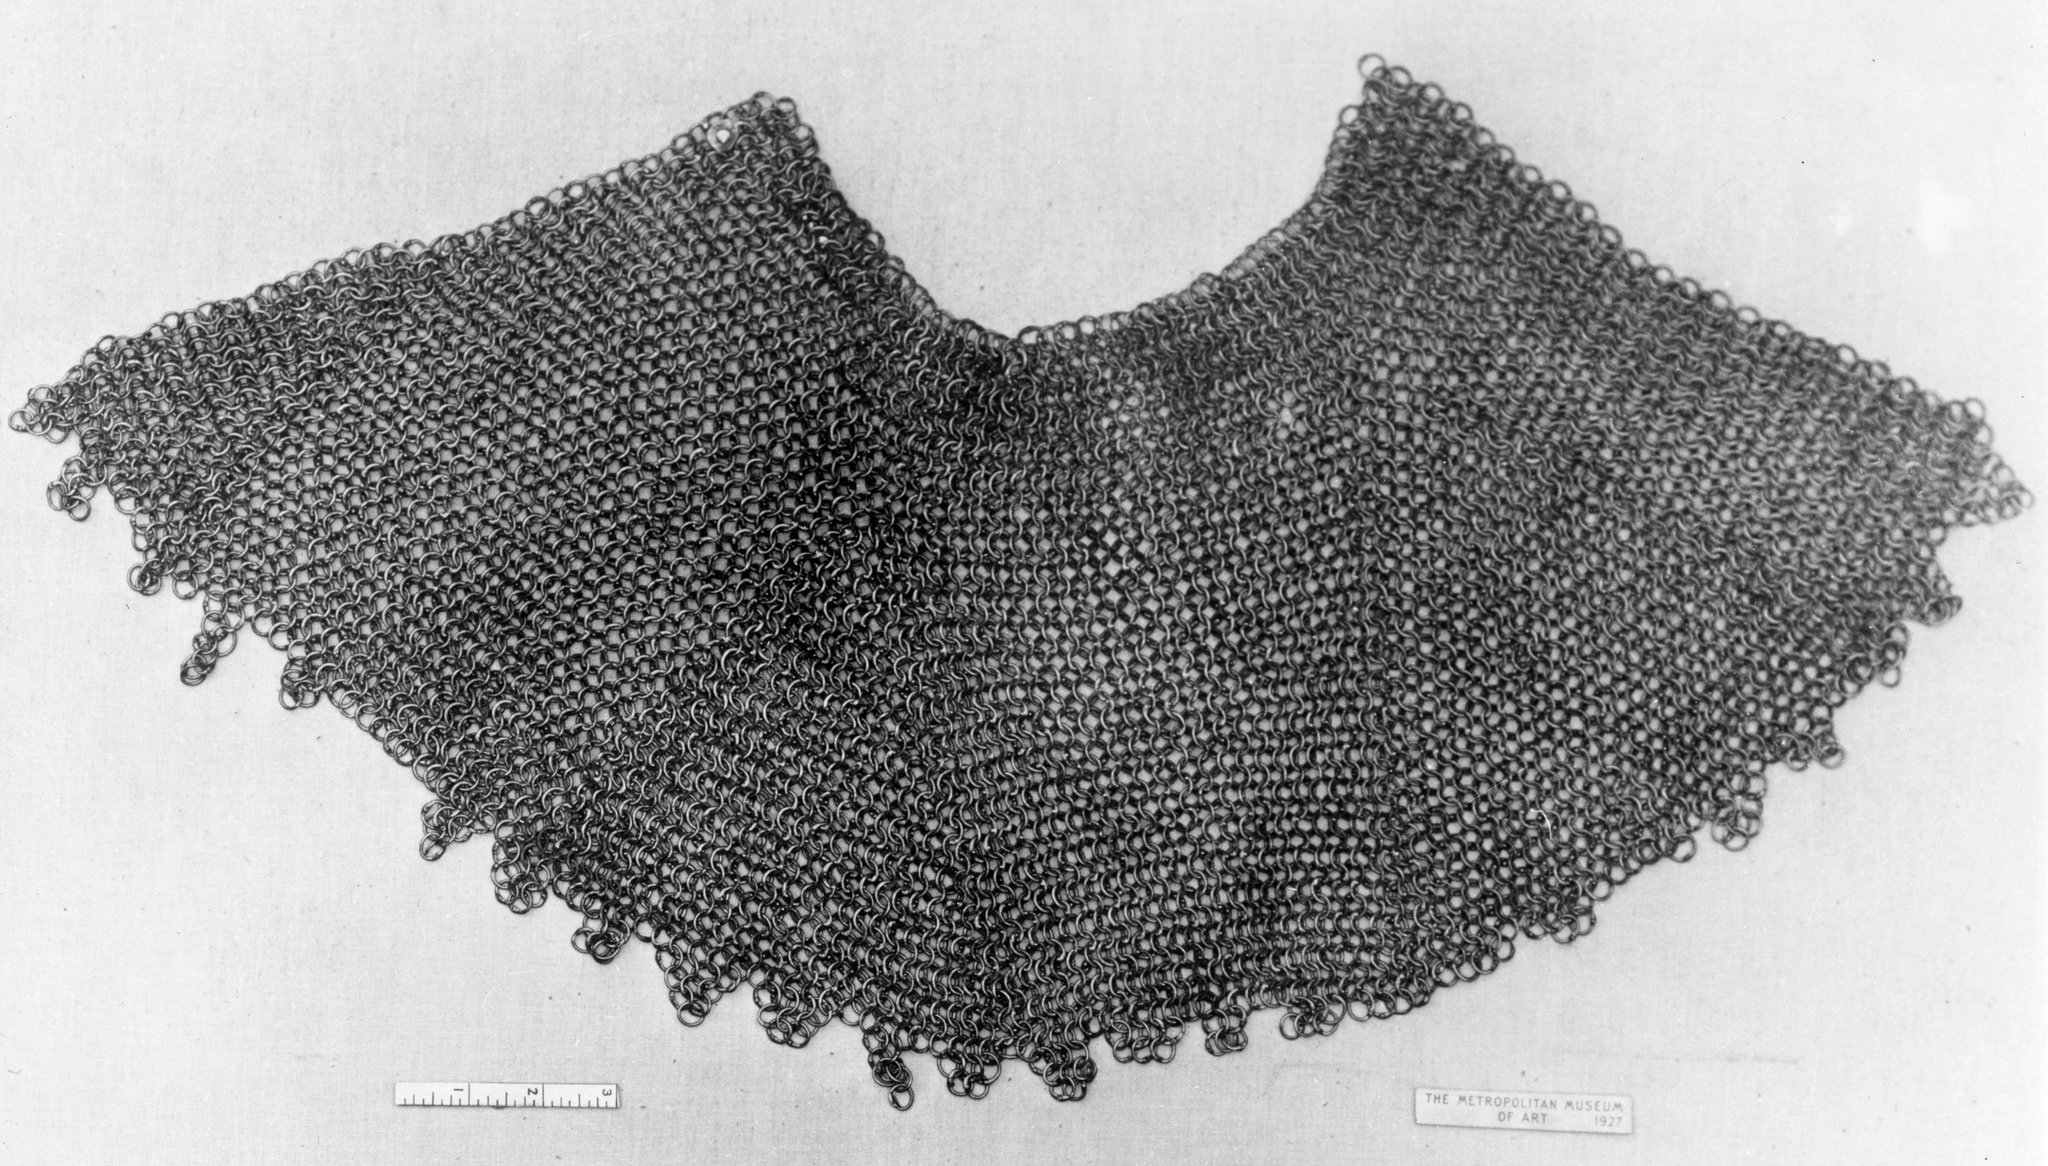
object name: collar of mail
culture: german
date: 1501-1600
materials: copper alloy, iron, steel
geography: germany